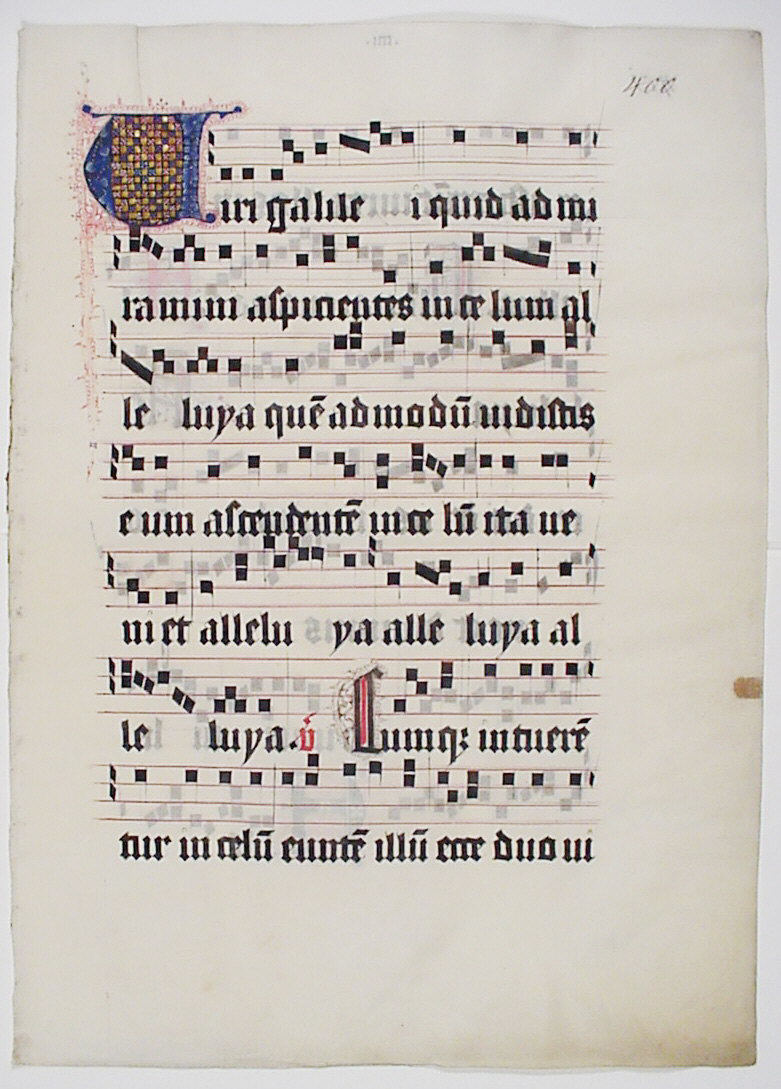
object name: gradual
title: Manuscript Leaf with Initial V, from a Gradual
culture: german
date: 1426-1450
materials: ink, metal leaf, parchment, paint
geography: germany